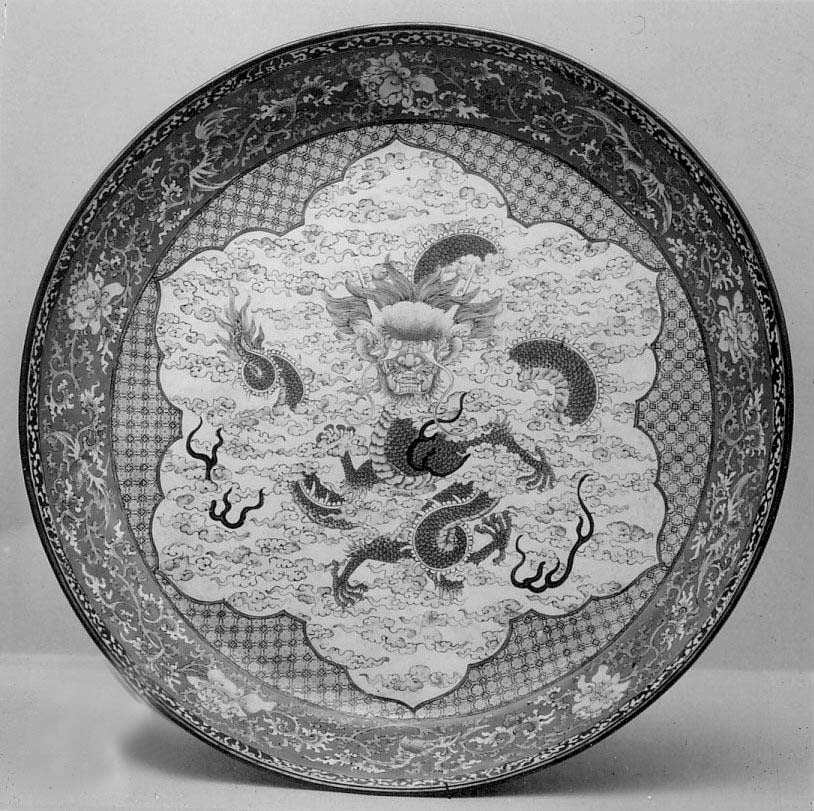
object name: dish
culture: chinese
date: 1736-1795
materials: enamel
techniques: painting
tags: dragons